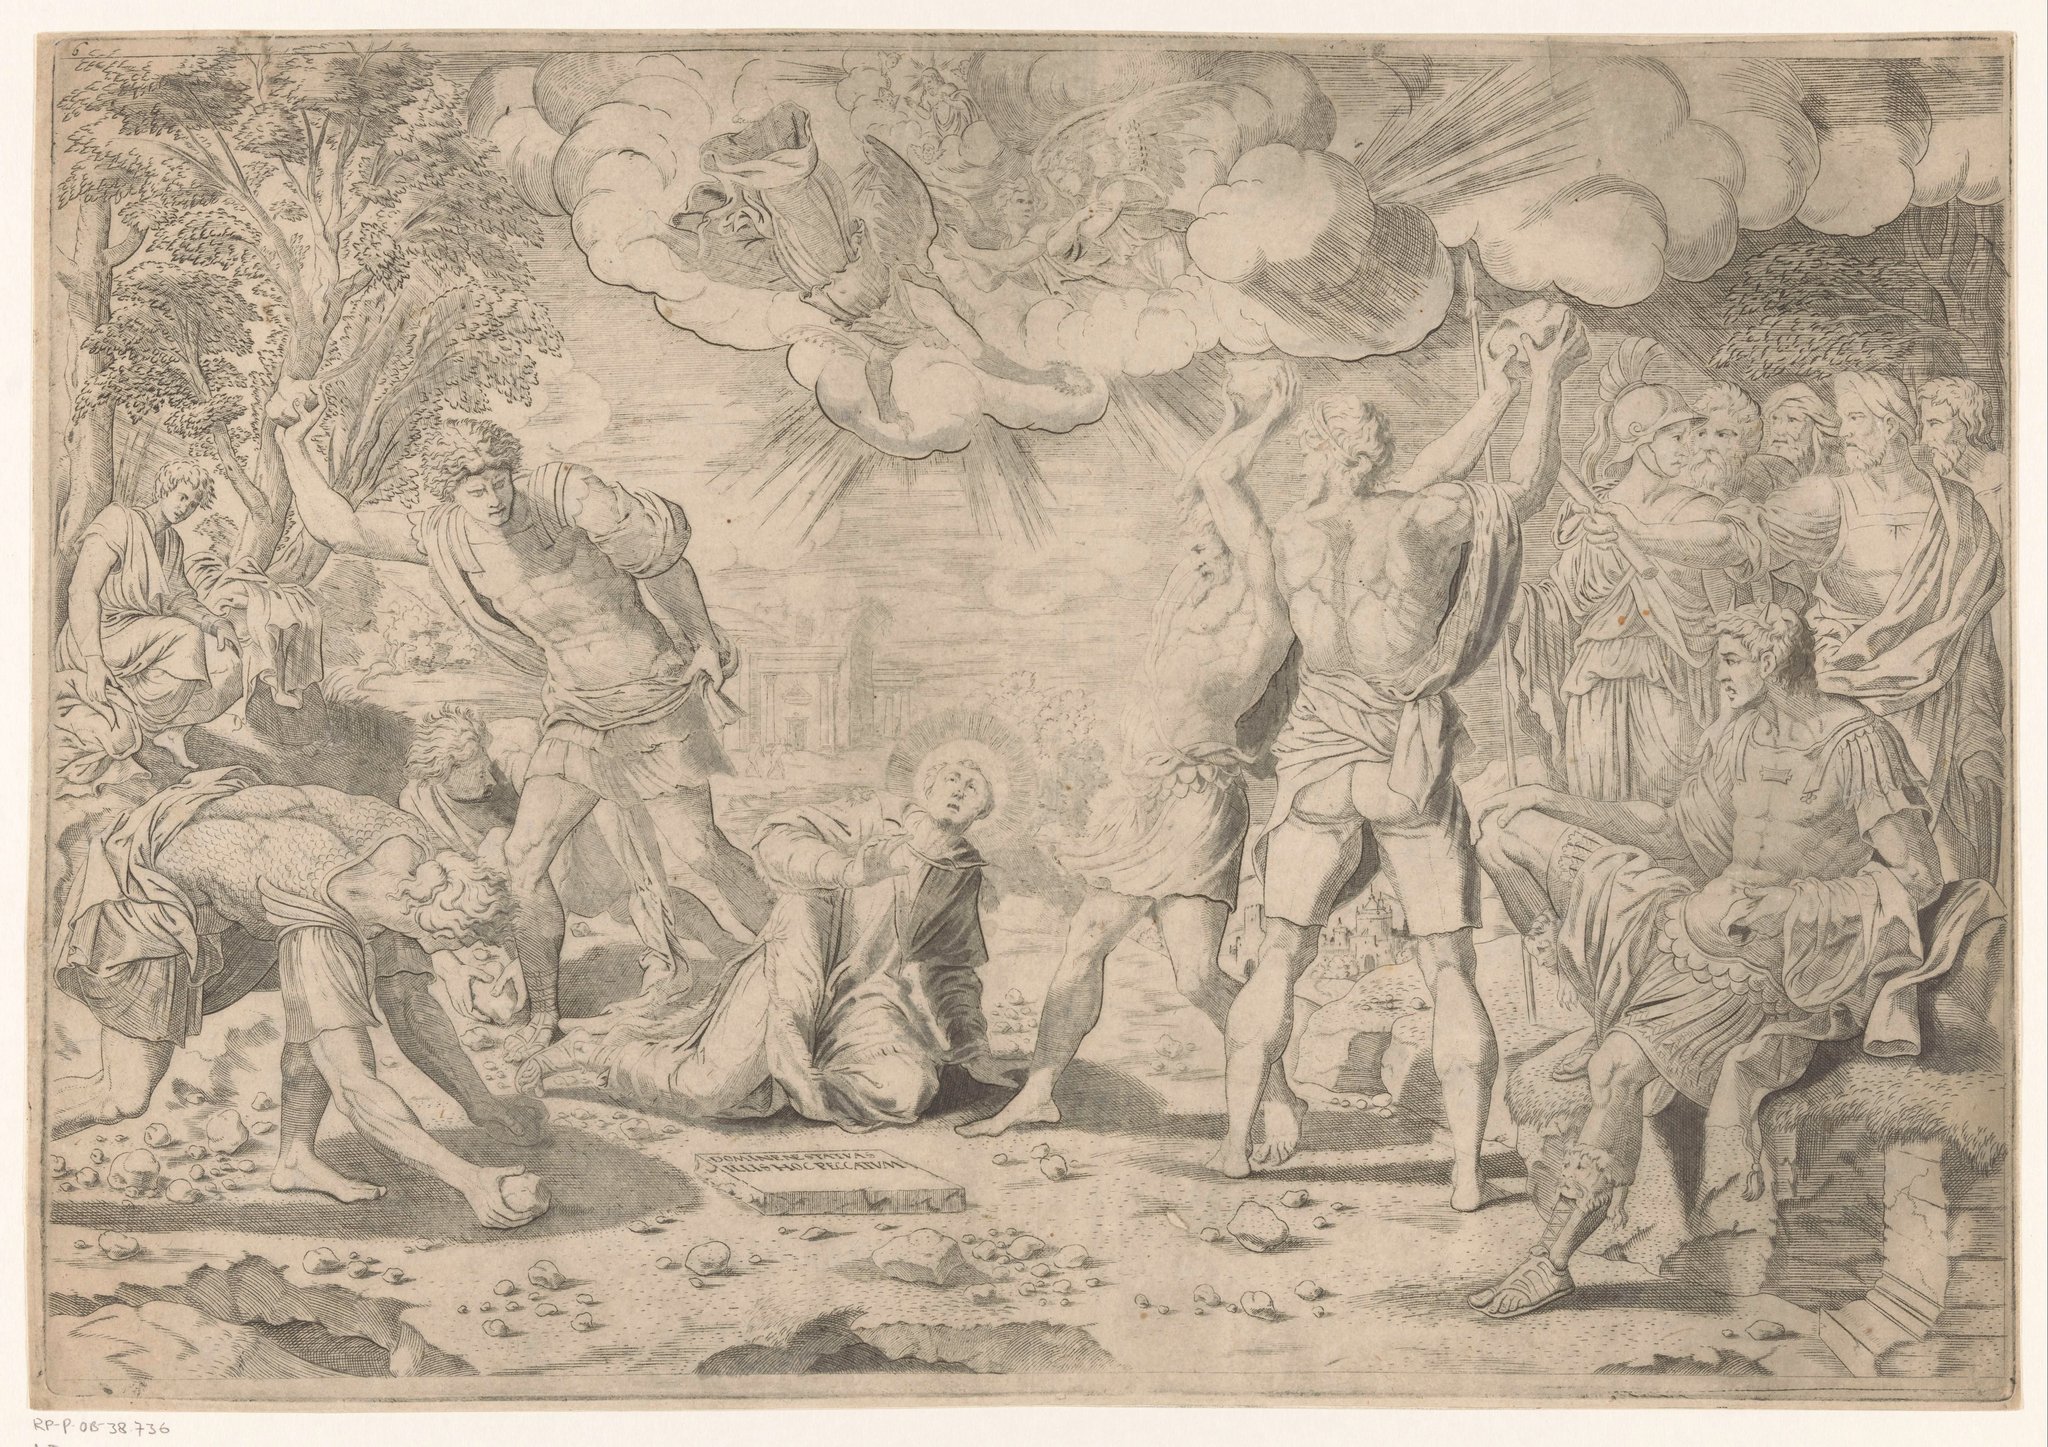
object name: print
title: Steniging van de heilige Stefanus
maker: Anonymous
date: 1550-1649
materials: paper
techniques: engraving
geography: italy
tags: cherubs, i.e. children's heads with wings, the stoning of stephen; the witnesses lay down their clothes at saul's feet, angels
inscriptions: collector's mark: Lugt 240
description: De heilige Stefanus in het midden, zittend op zijn knieën. Om hem heen figuren die stenen naar hem gooien. In de lucht Christus, cherubijnen en engelen.